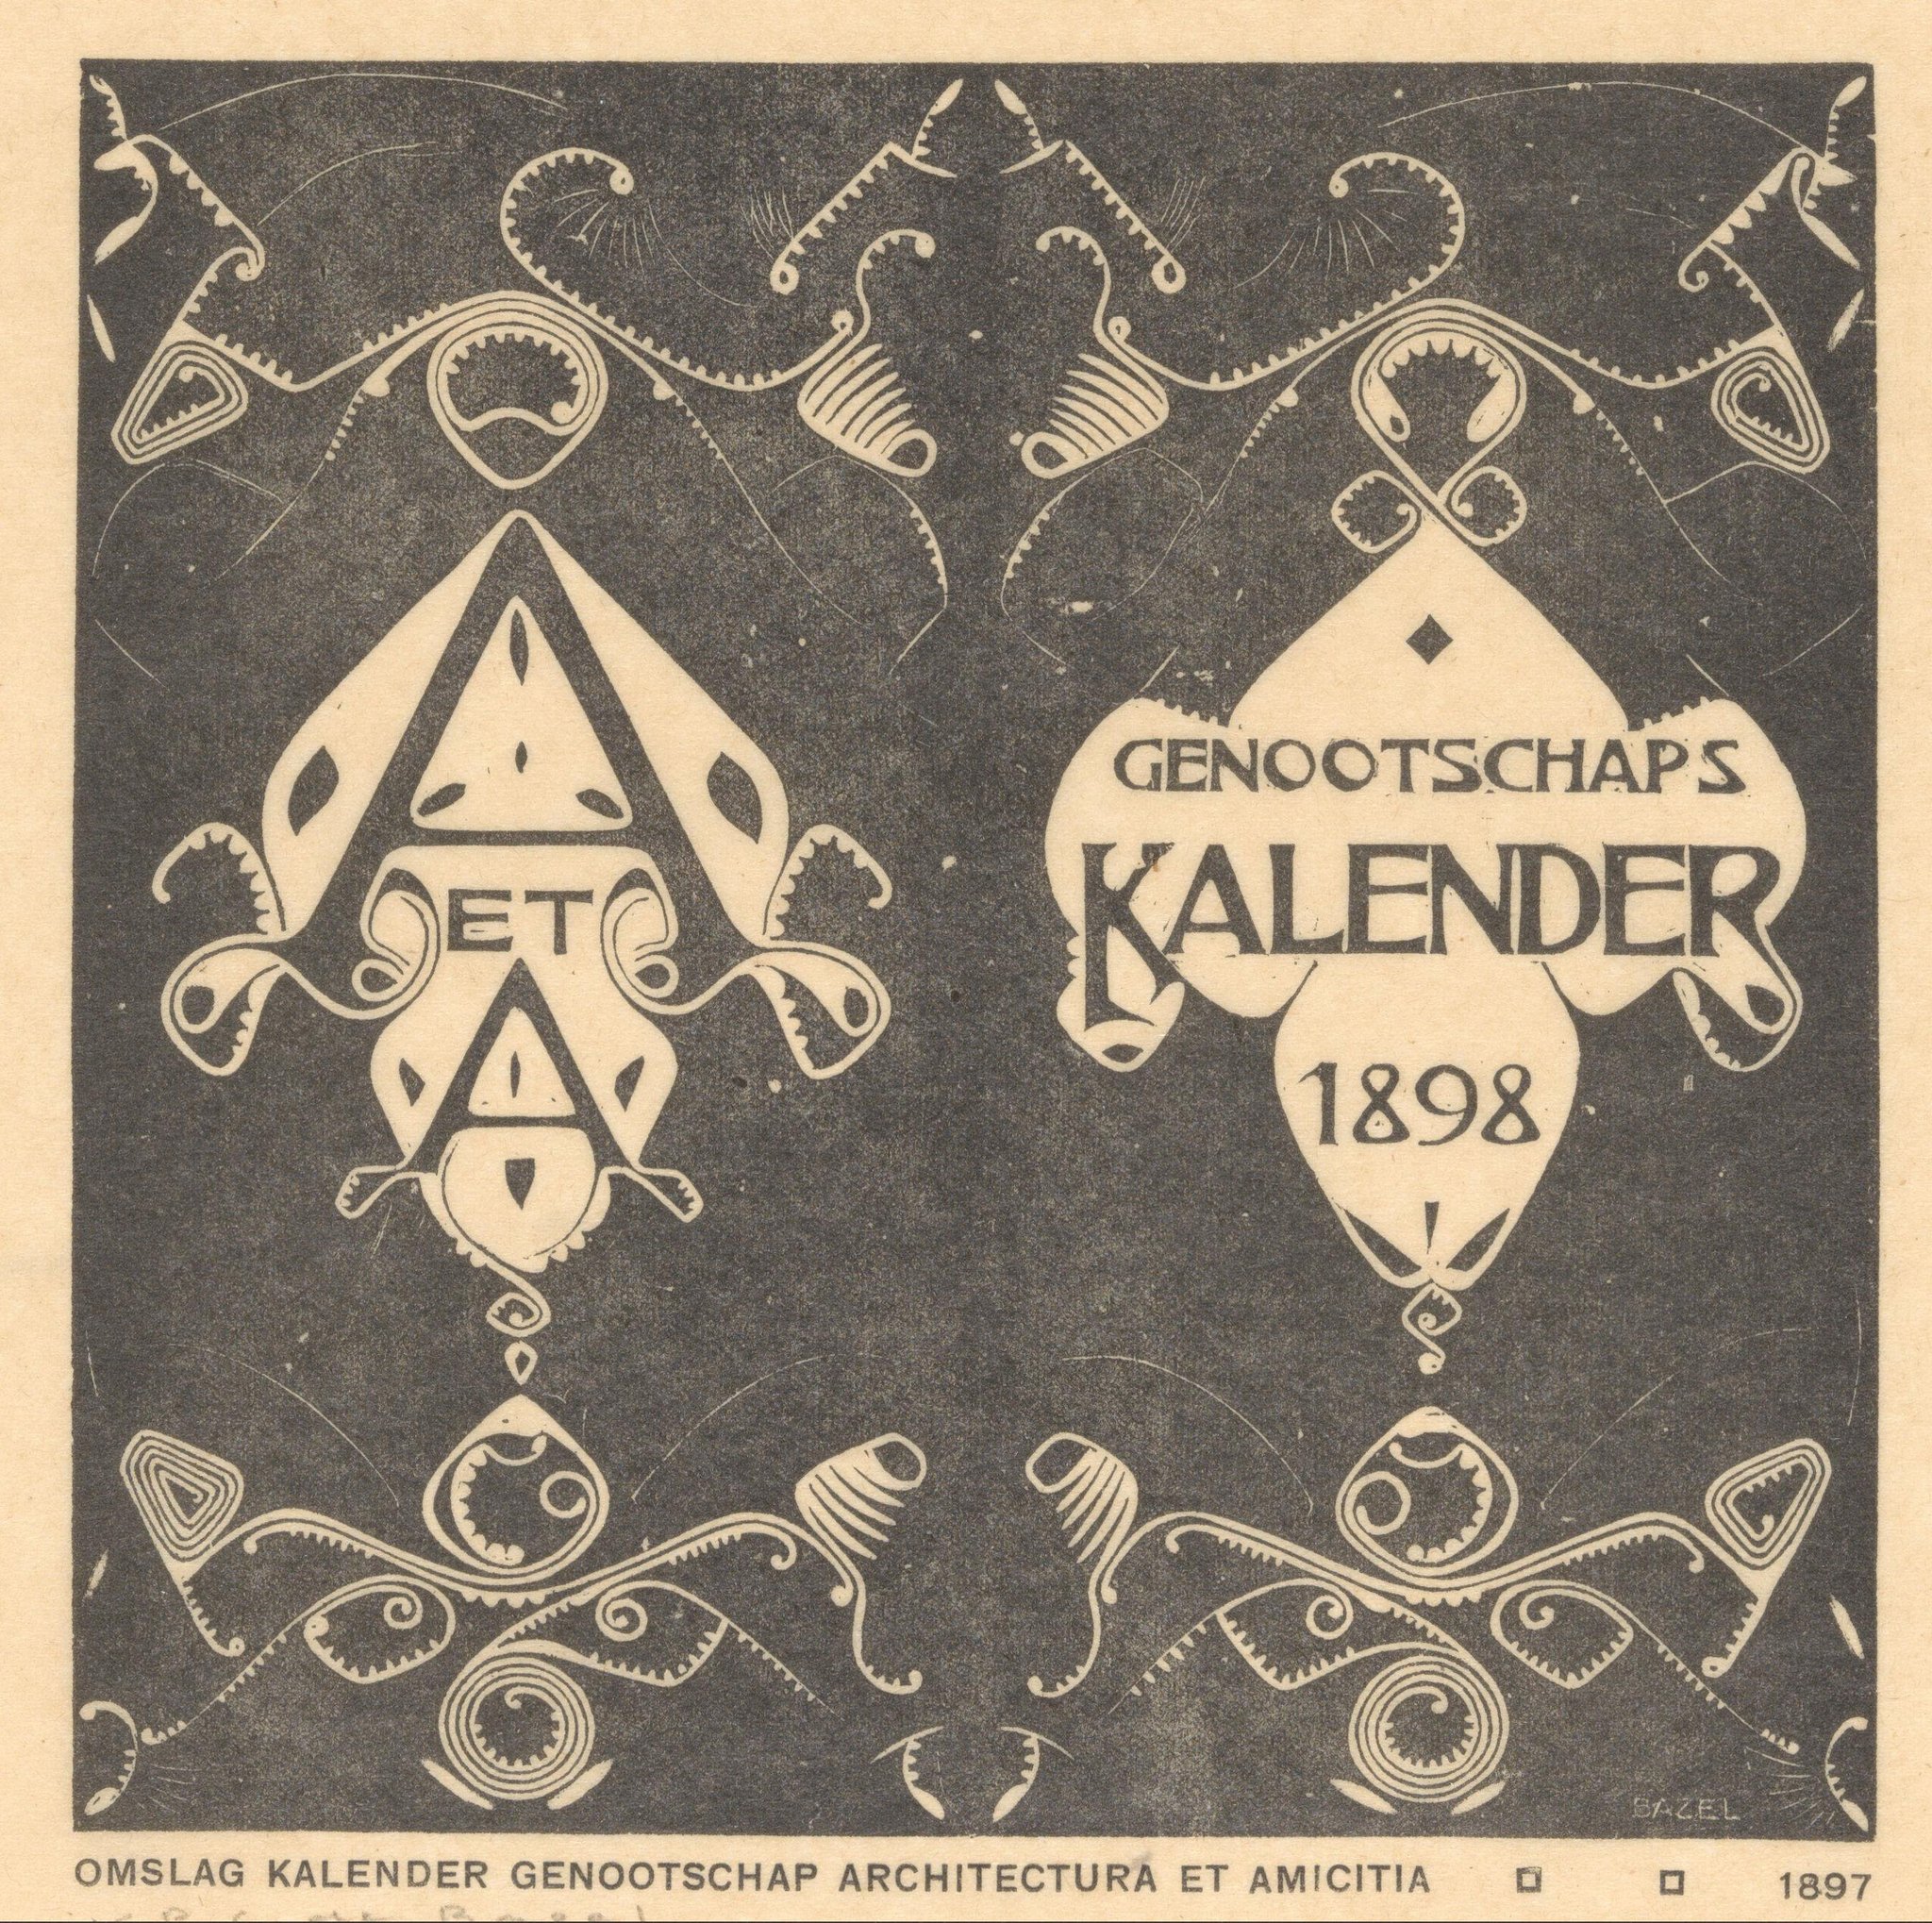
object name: calendar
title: Omslag kalender Architectura et Amicitia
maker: karel petrus cornelis de bazel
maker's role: draughtsman, print maker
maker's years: 1869-1923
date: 1897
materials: paper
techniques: woodcut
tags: calendar, almanac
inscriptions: annotation: ‘omslag kalender genootschap architectura et amicitia, 1897’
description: Prent afkomstig uit: Wendingen. Amsterdam: De Hooge Brug, 1919. Jaargang 2, nummer 7-8. De huidige titel is door het museum toegekend bij gebrek aan informatie over een originele titel.